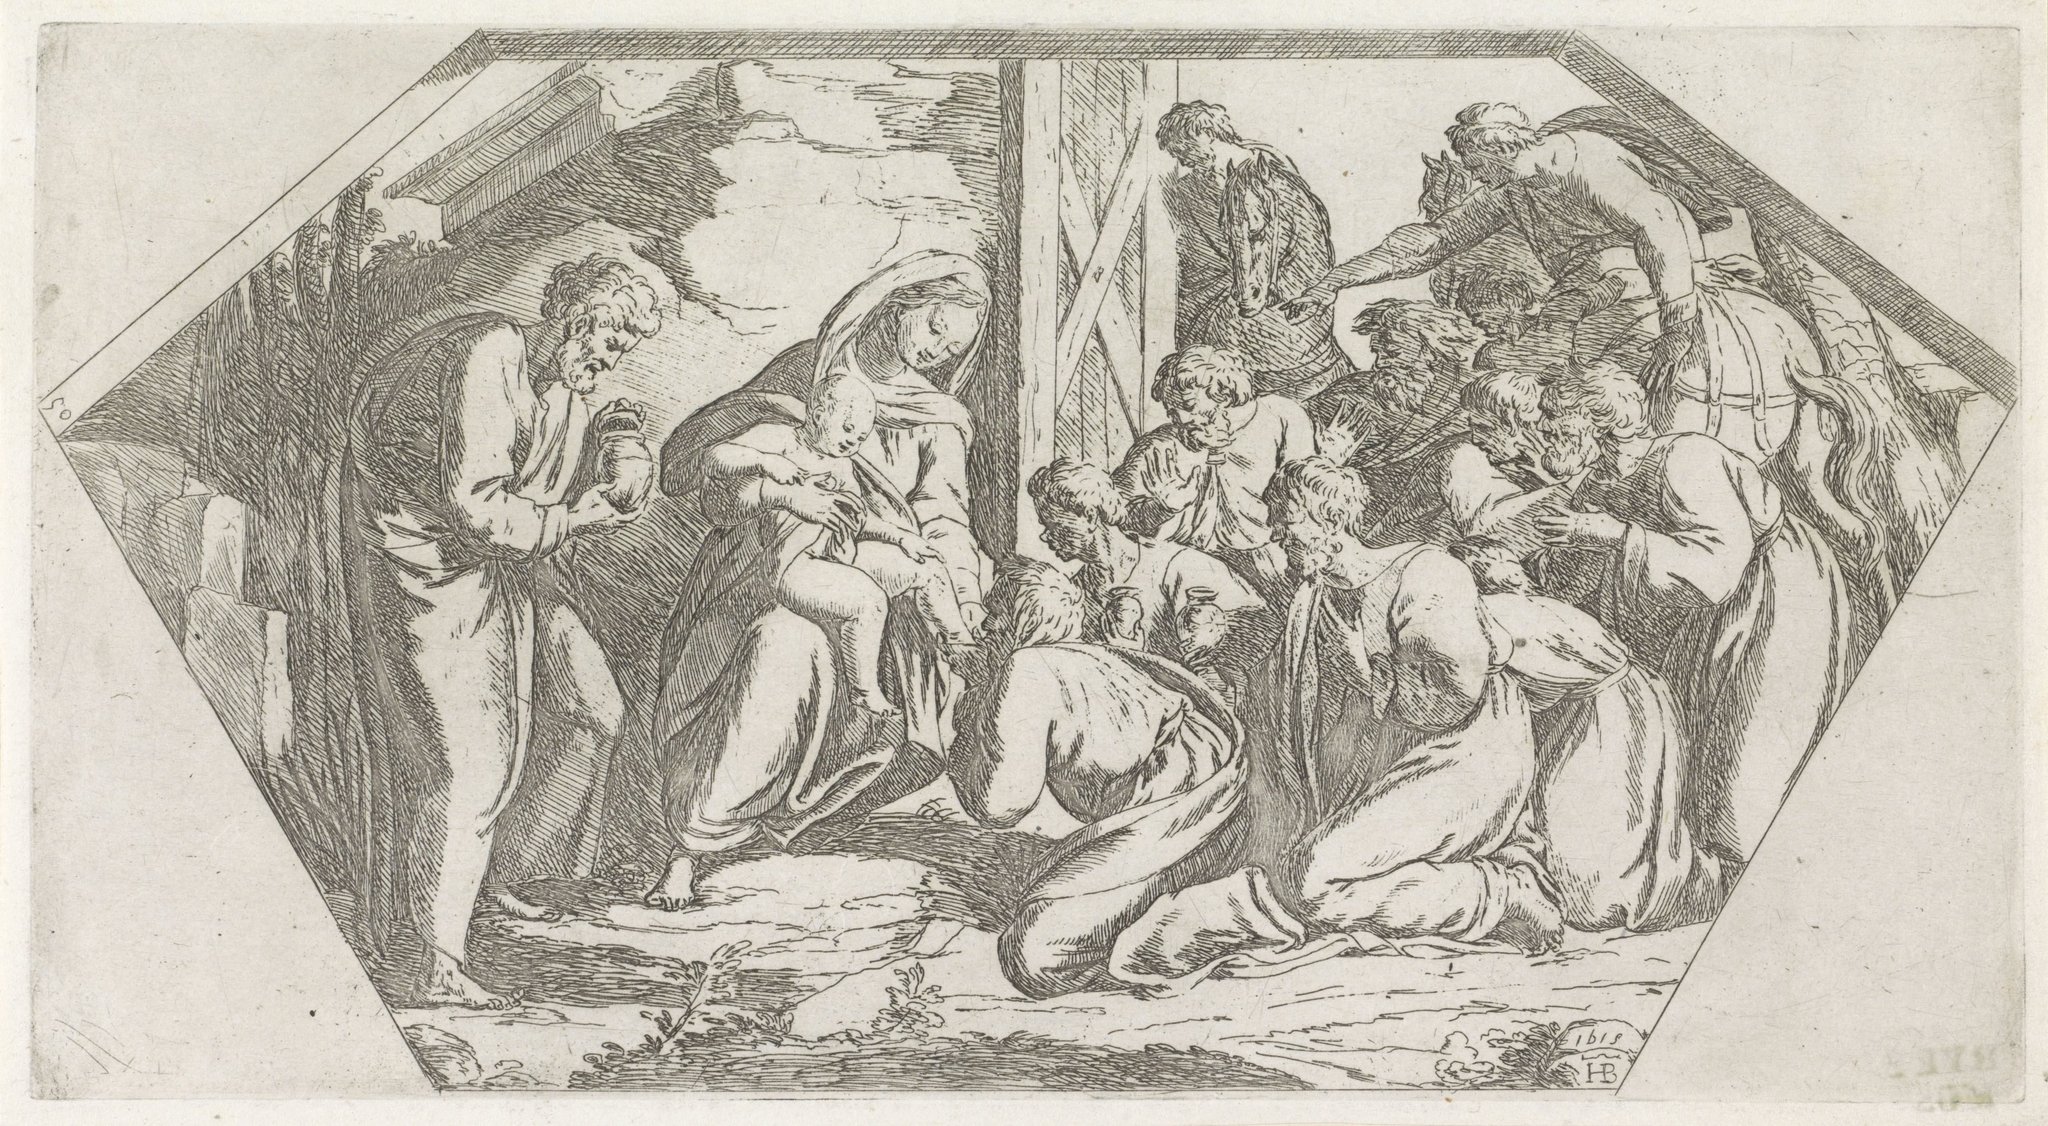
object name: print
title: Schilderingen in de Loggia van Rafaël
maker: orazio borgianni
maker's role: print maker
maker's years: 1578-1616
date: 1615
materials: paper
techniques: etching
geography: italy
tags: adoration of the kings: the wise men present their gifts to the christ-child (gold, frankincense and myrrh)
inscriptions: collector's mark: Lugt 2165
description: Voor een stal aanbidden de drie koningen, Maria en Jozef het Christuskind. De koningen bieden geschenken aan.